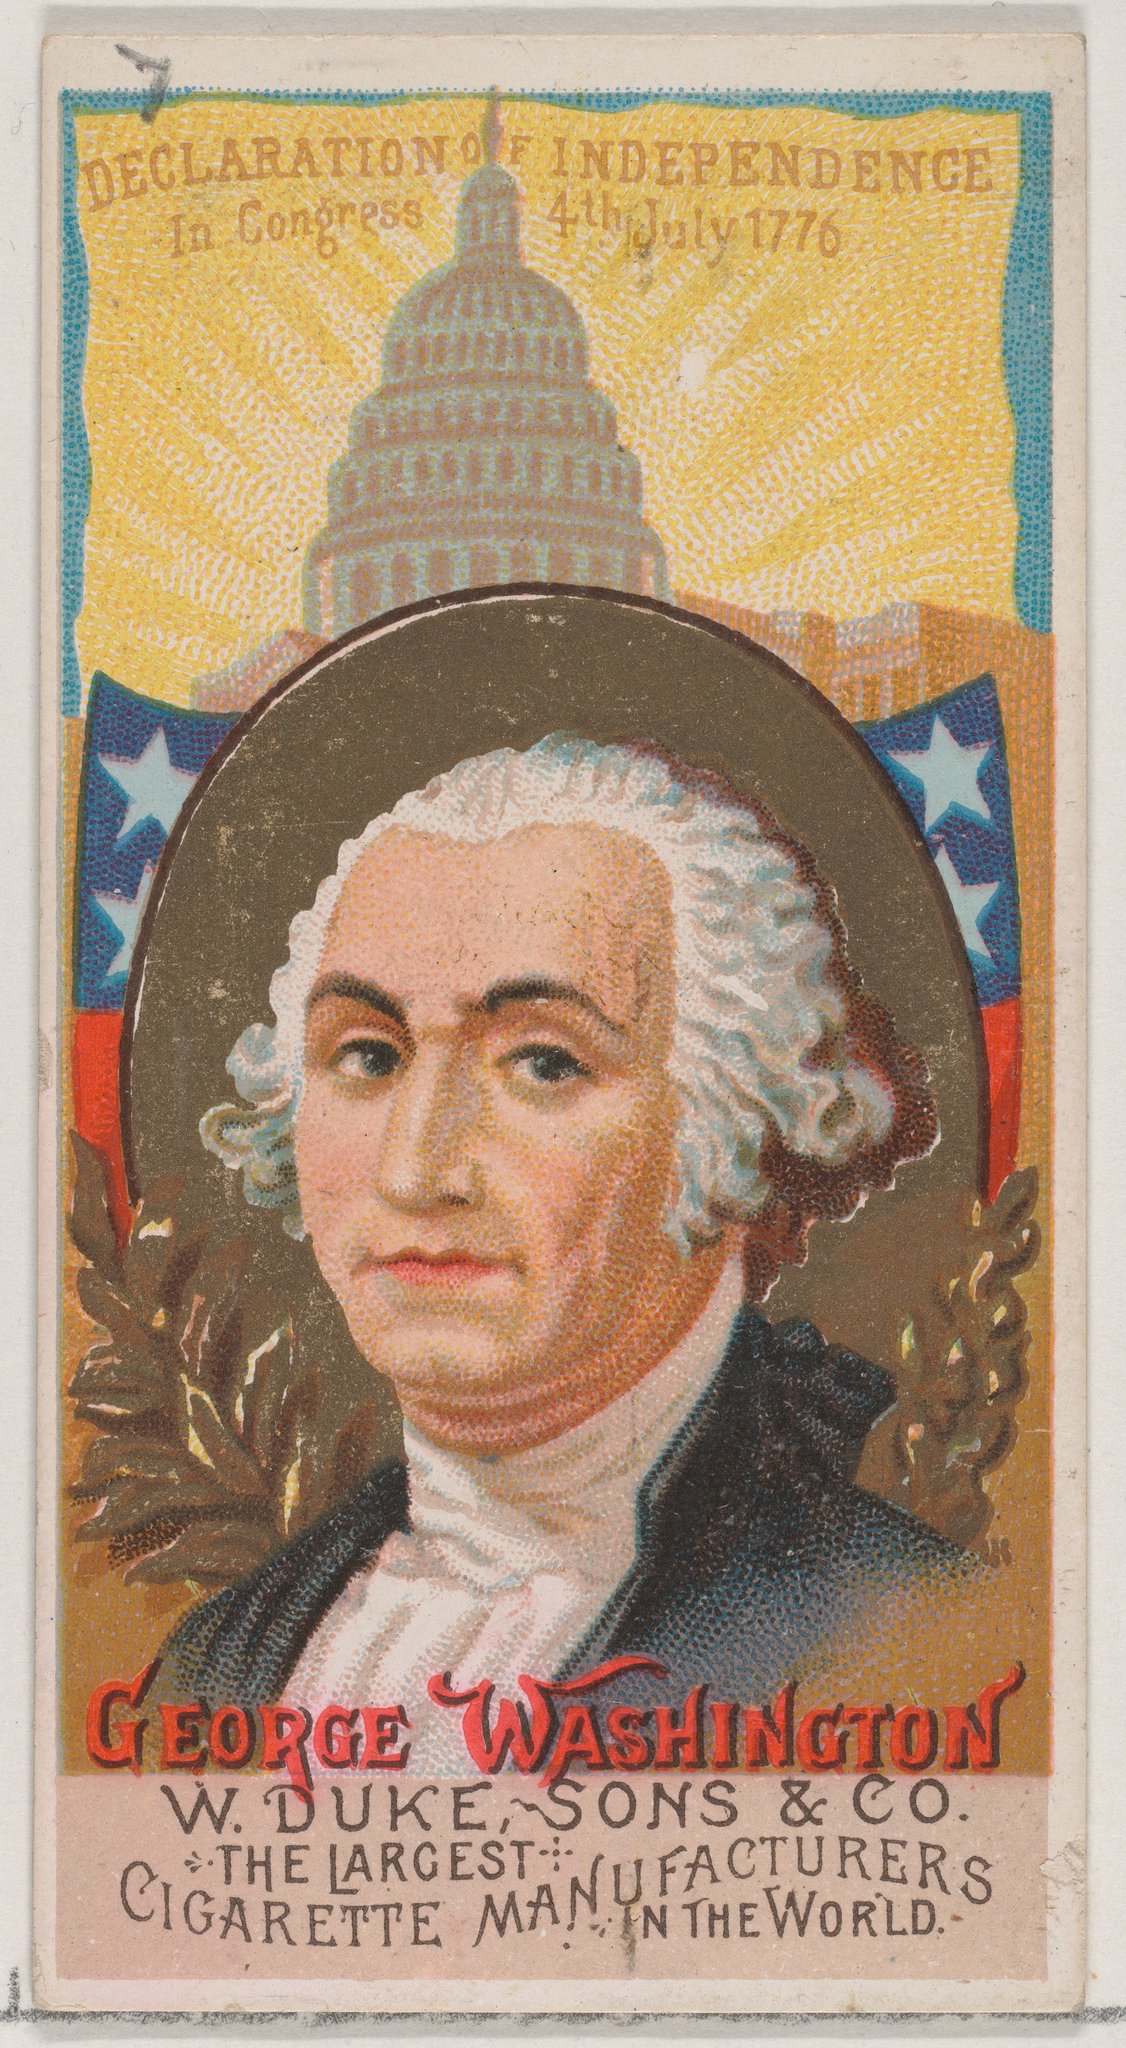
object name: print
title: George Washington, from the series Great Americans (N76) for Duke brand cigarettes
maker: w. duke, sons & co.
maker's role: publisher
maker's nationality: american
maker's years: 1870-1920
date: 1888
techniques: color lithograph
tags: men